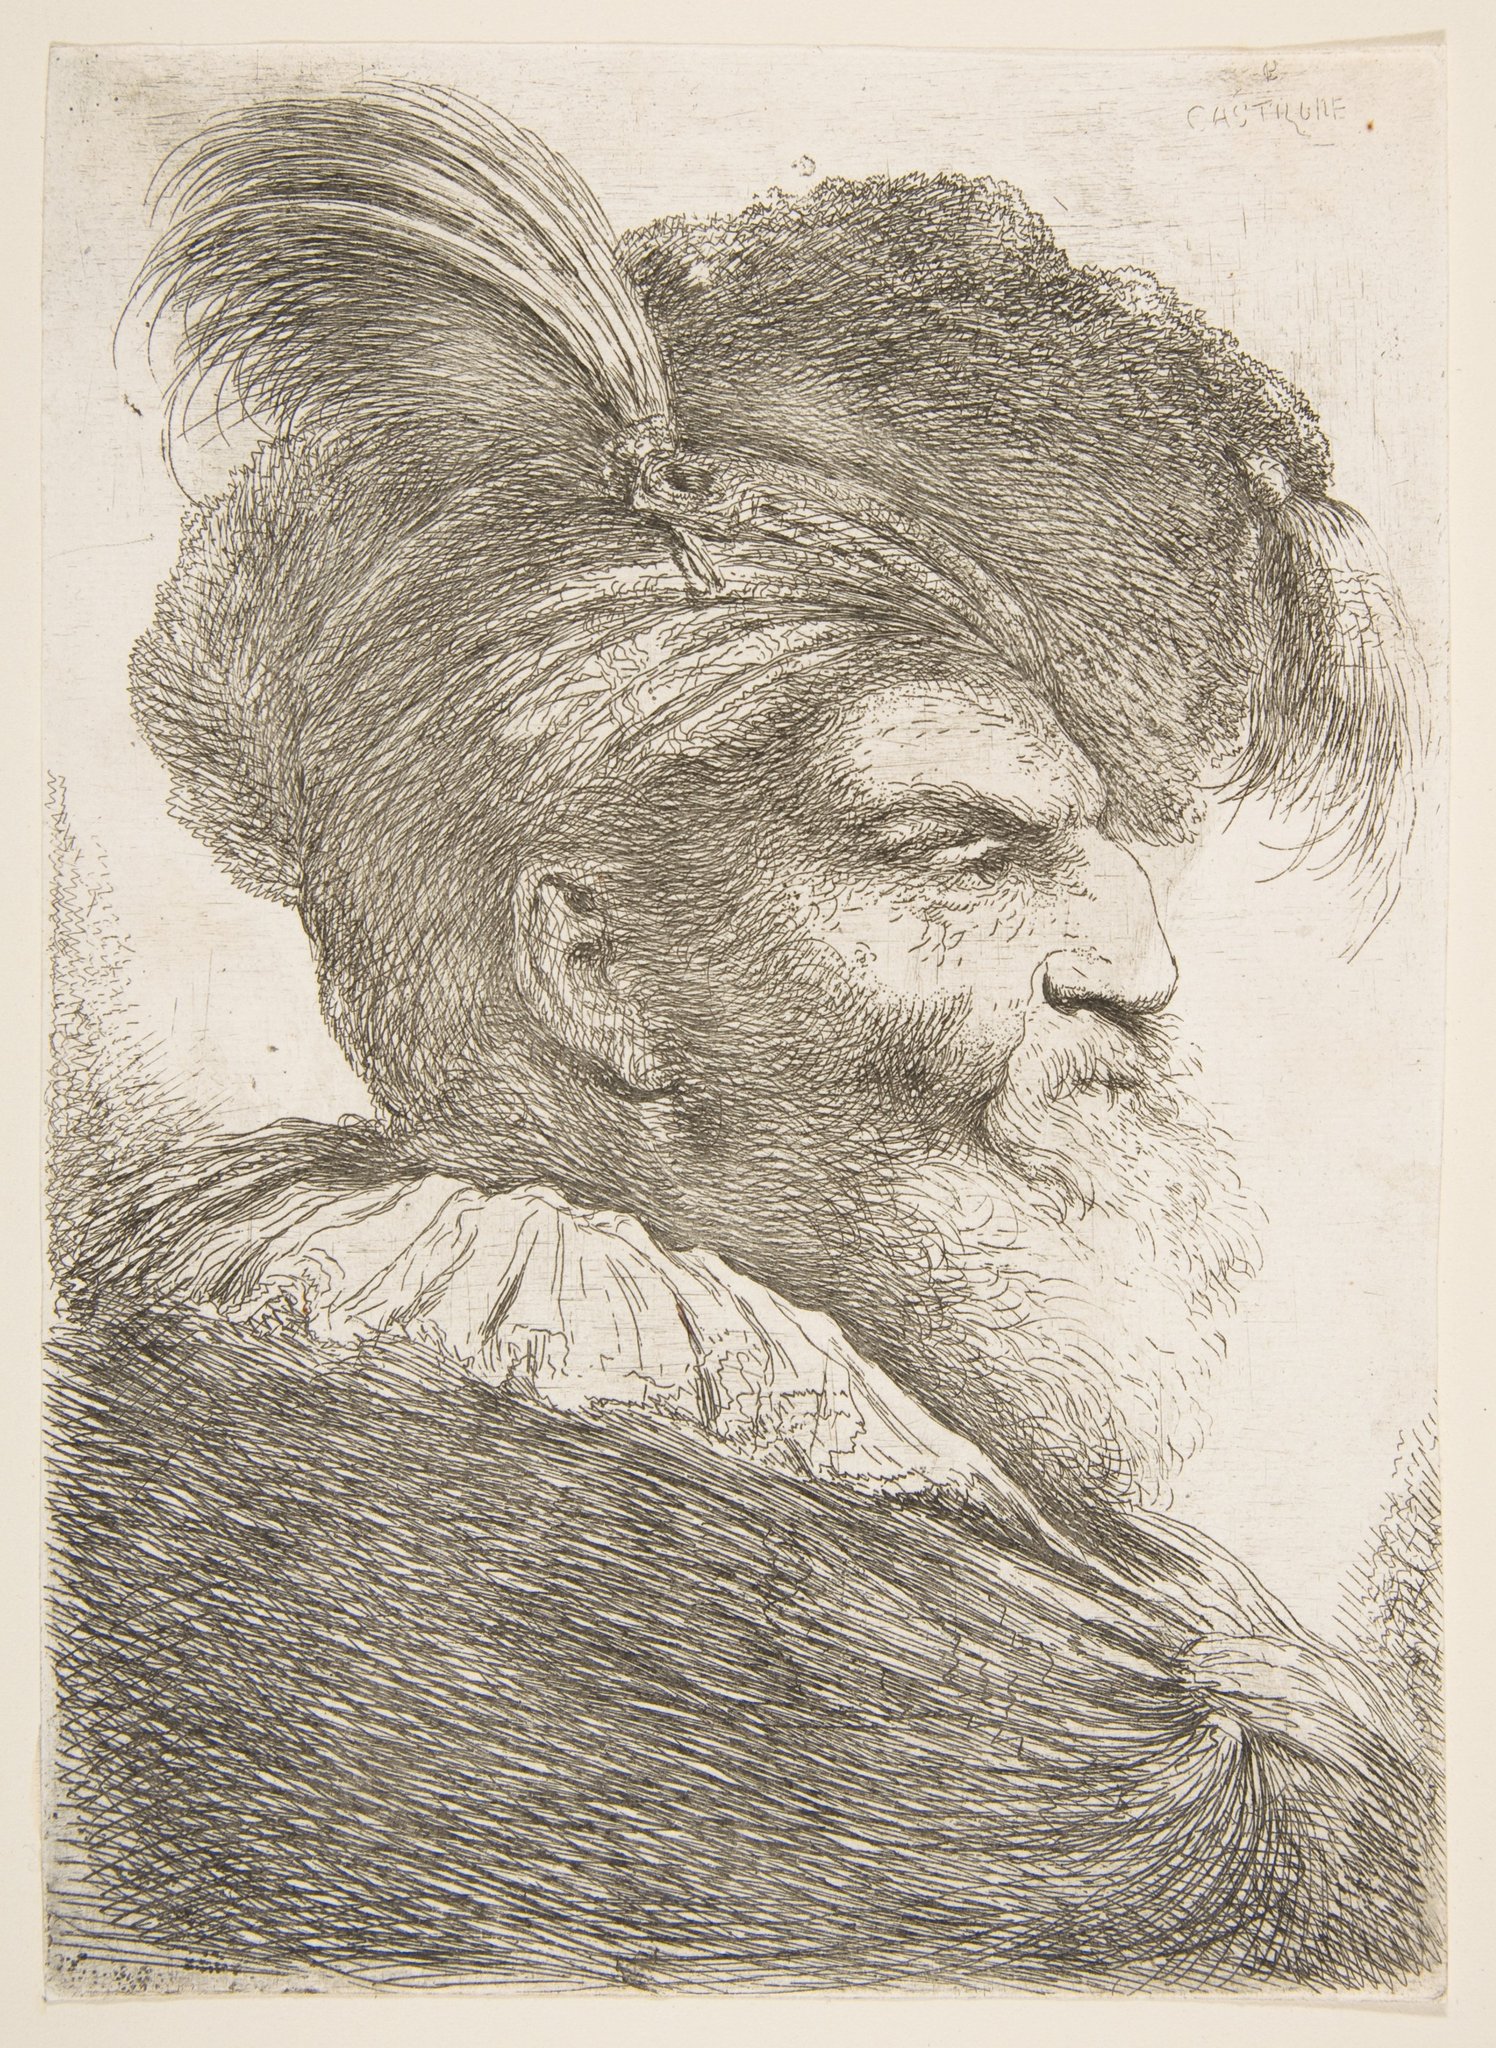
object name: print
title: Head of an old man facing right, from "Large Oriental Heads"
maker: giovanni benedetto castiglione (il grechetto)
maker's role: artist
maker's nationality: italian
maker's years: 1609-1664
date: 1645-1650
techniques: etching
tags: men,portraits